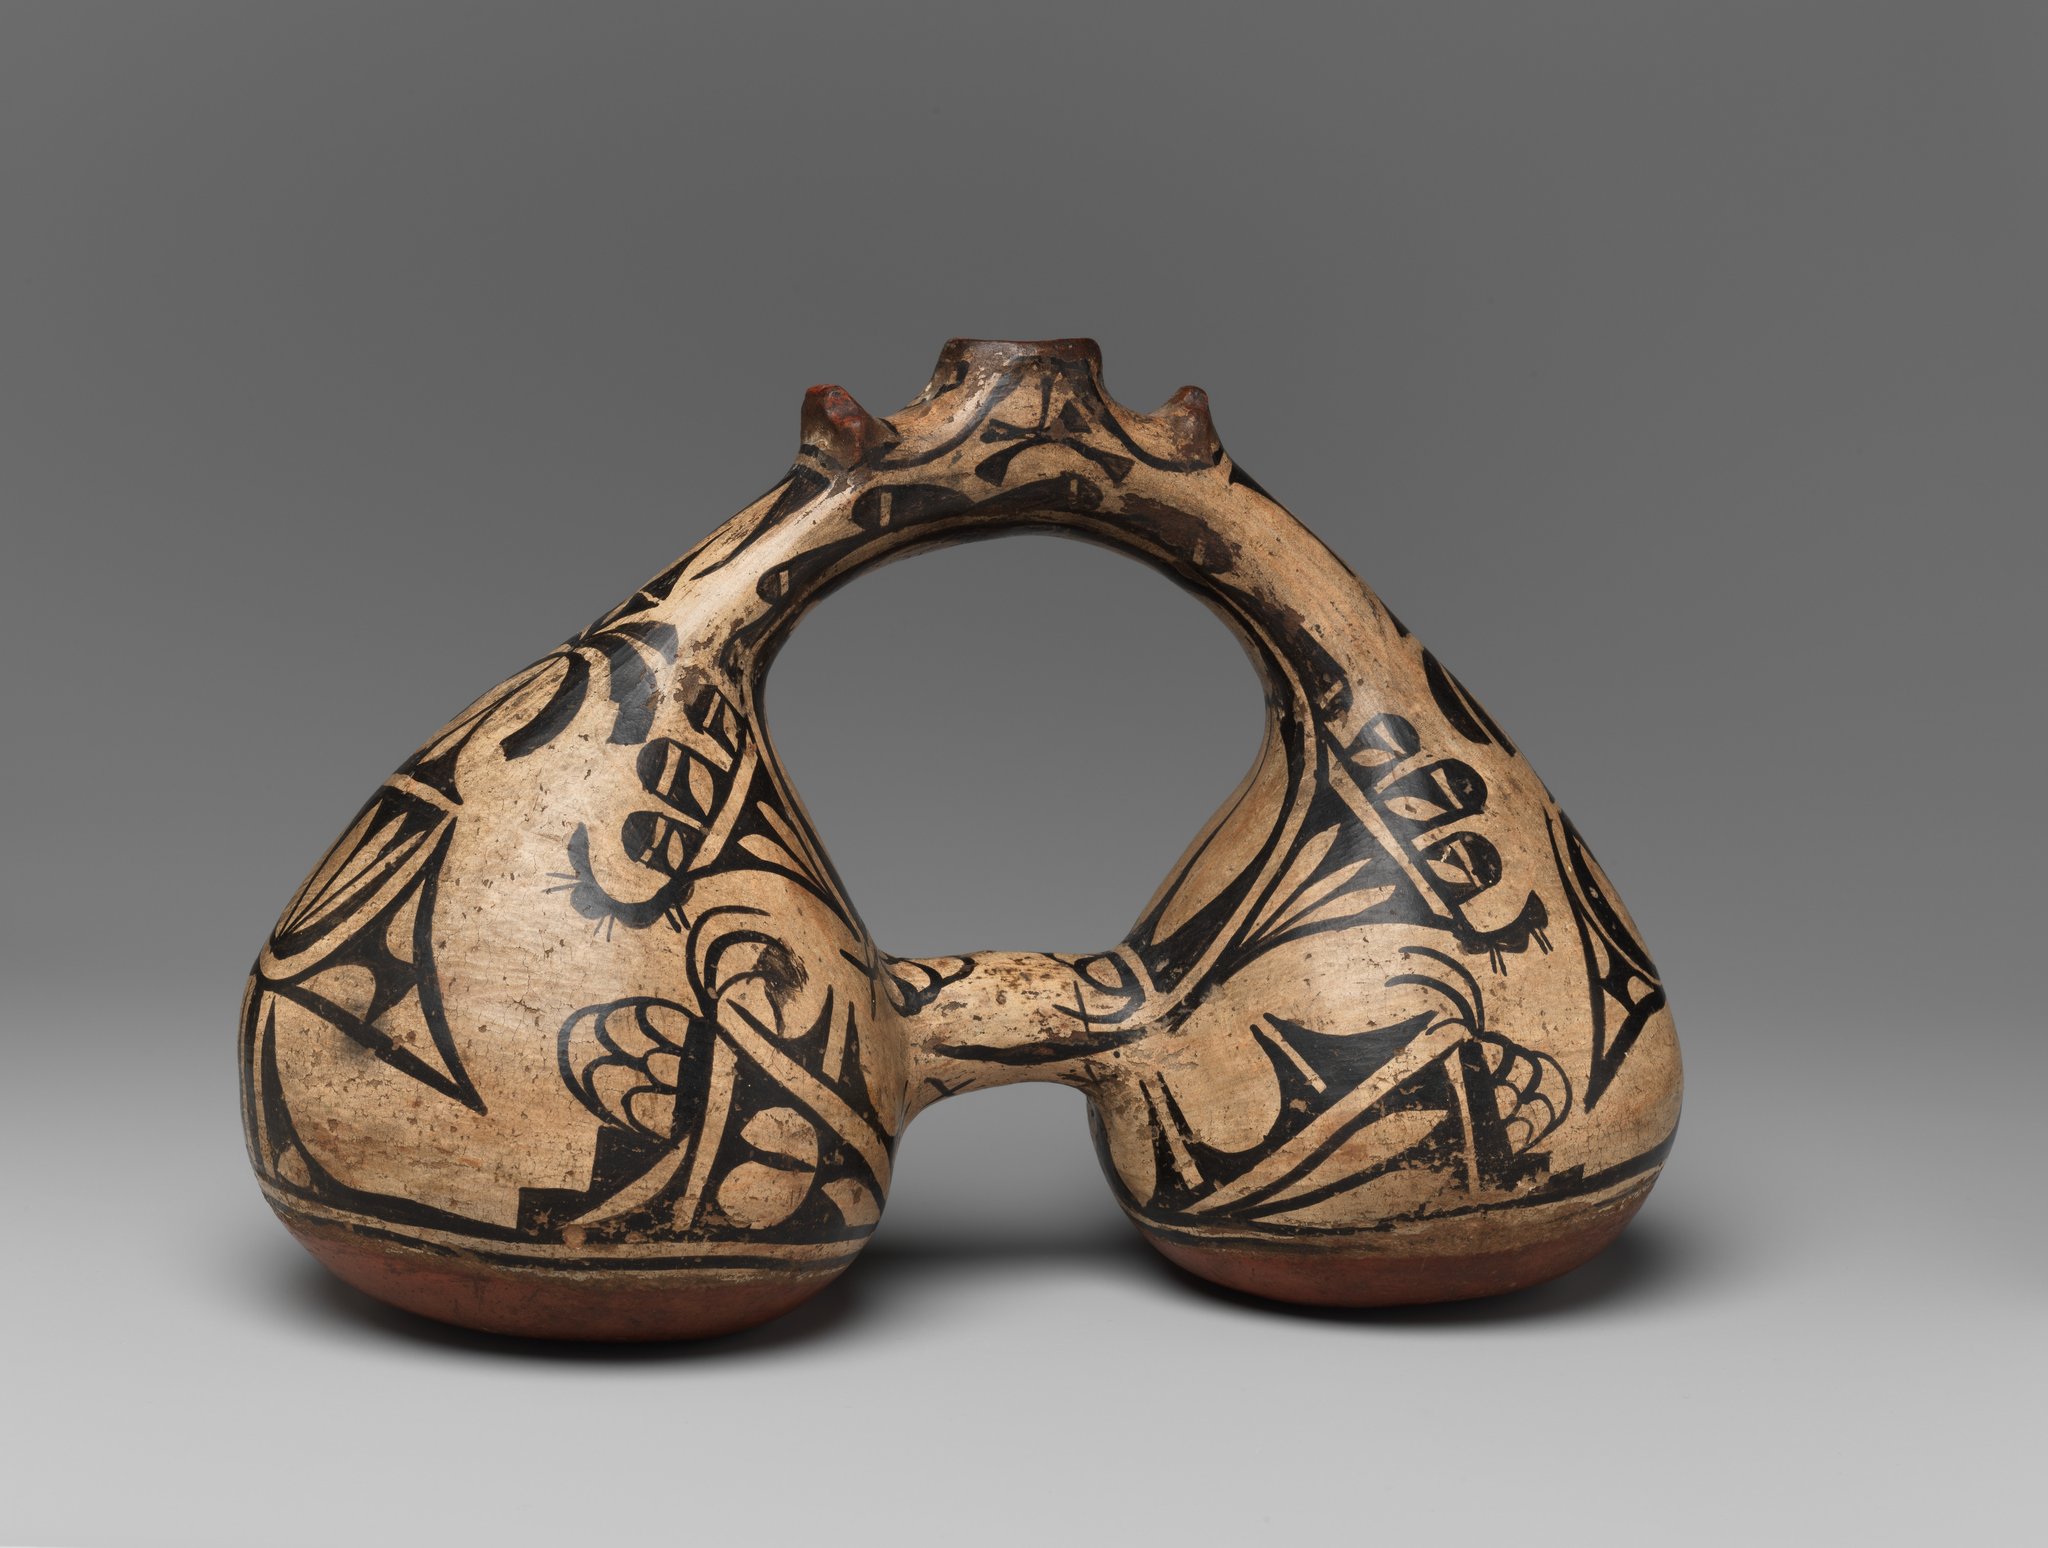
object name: double lobed canteen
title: Double-lobed polychrome canteen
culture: tewa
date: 1860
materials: clay, pigment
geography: united states